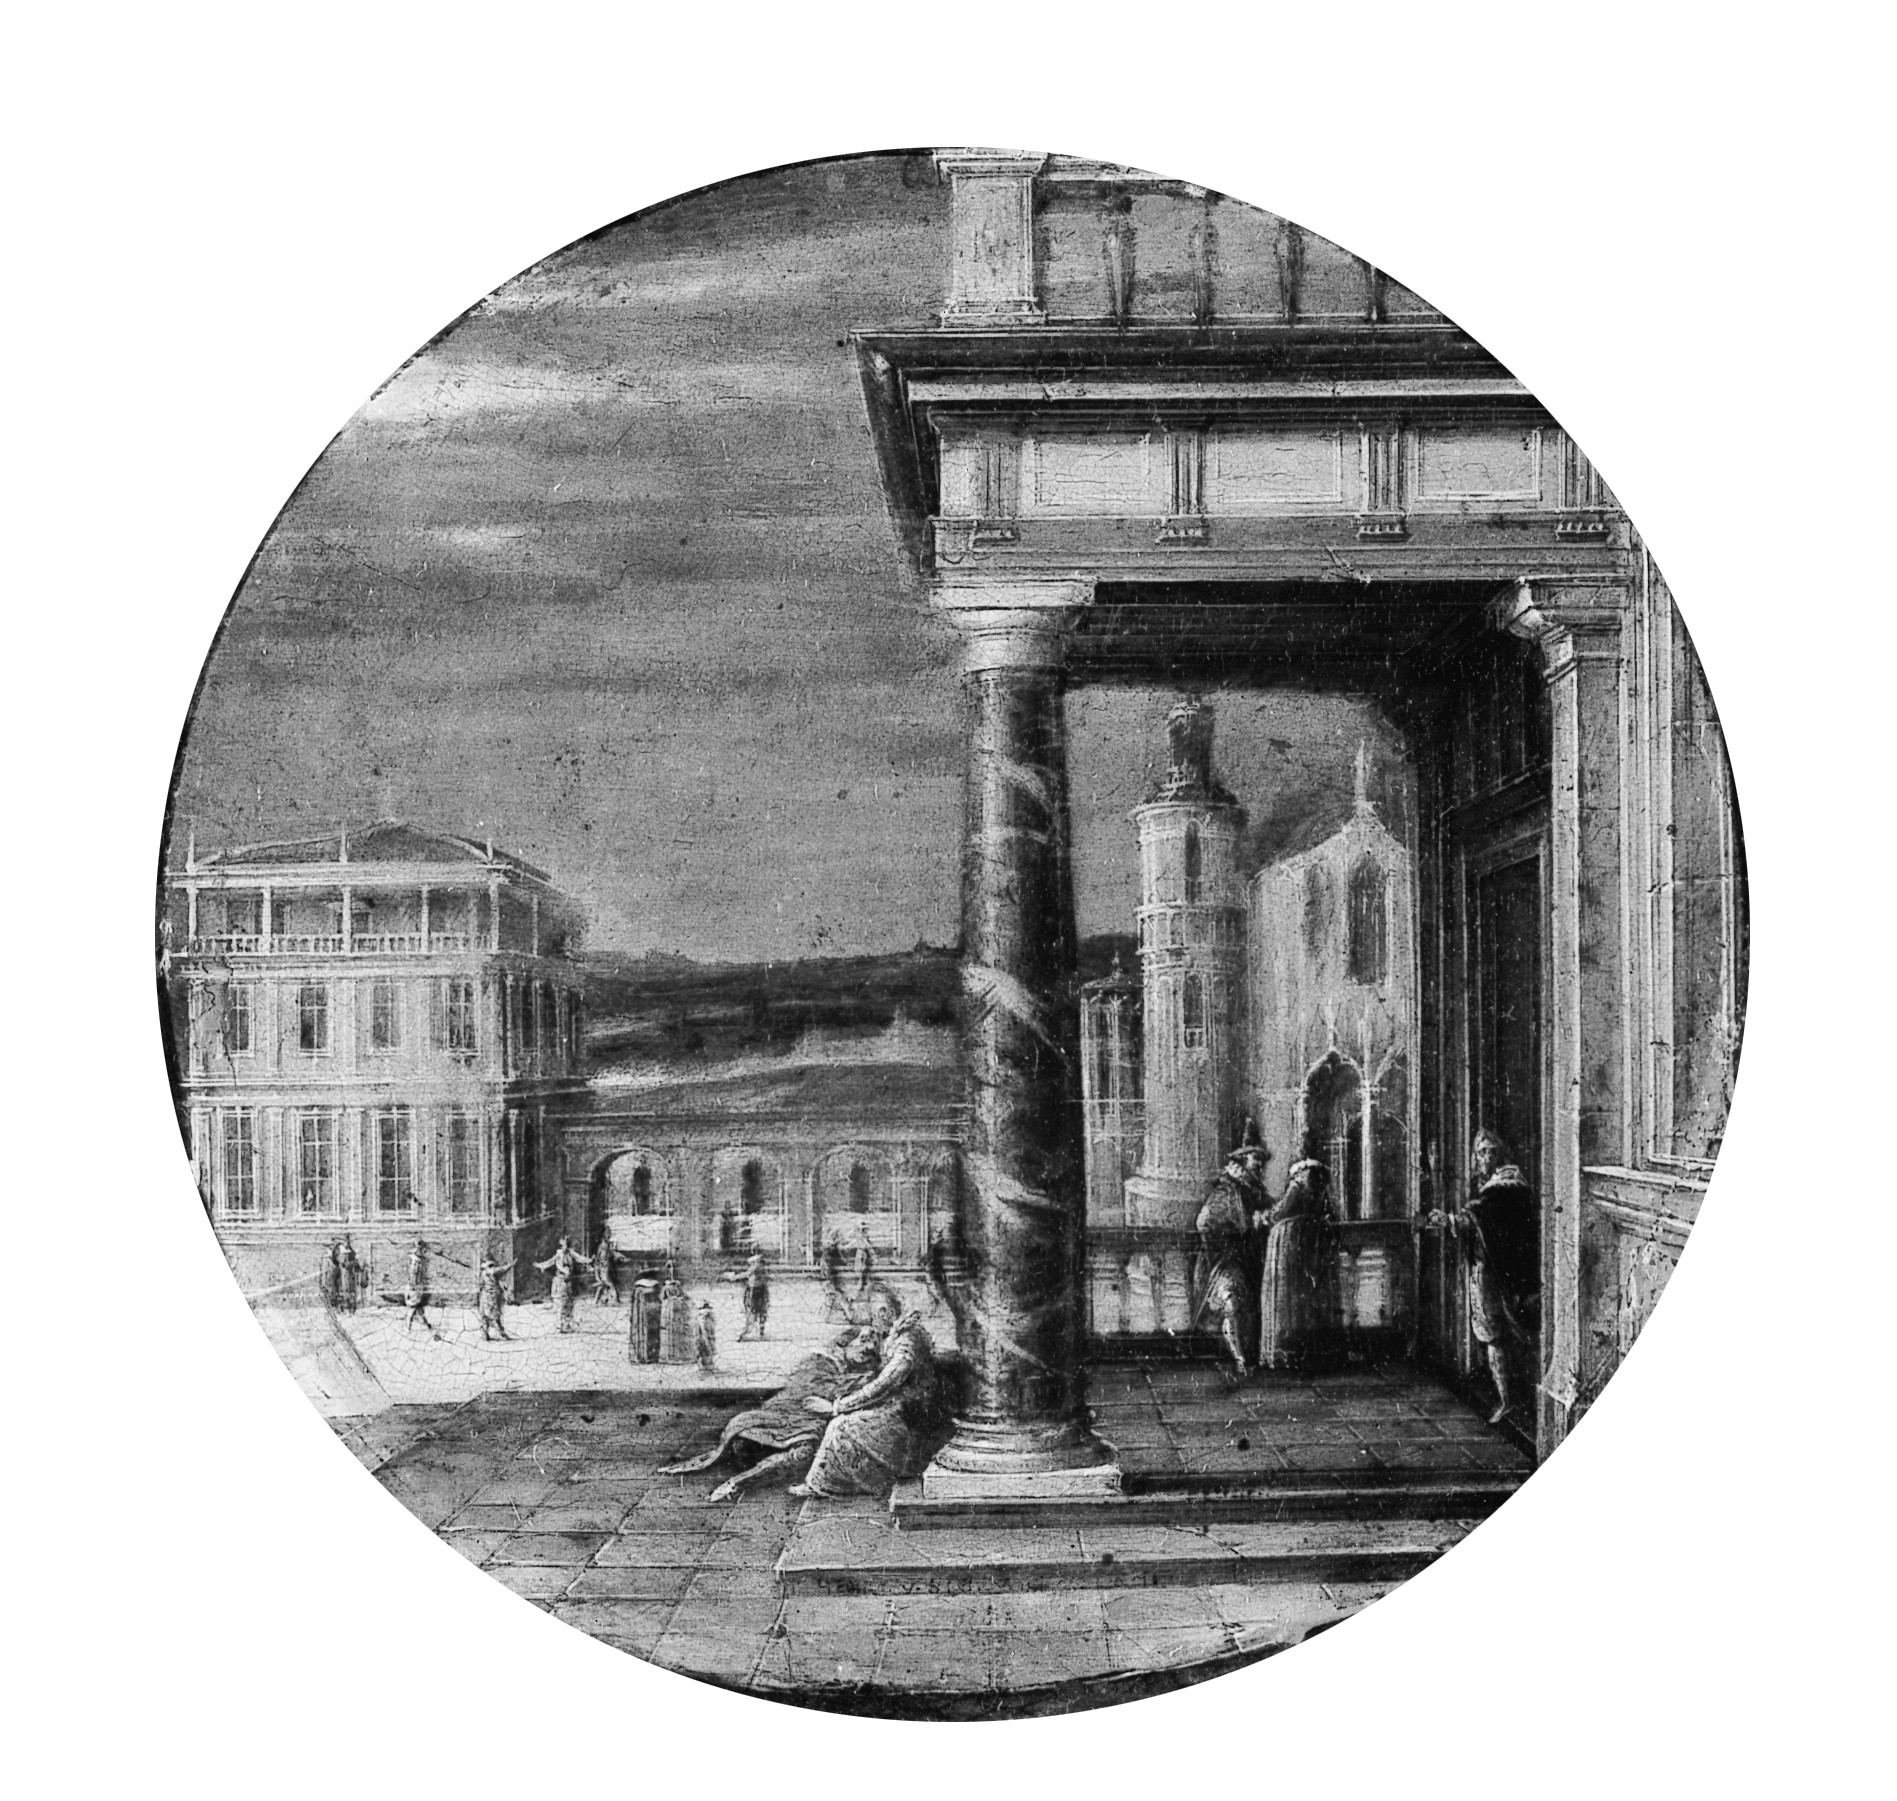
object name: painting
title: A Renaissance Portico with Elegant Figures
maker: hendrick van steenwijck ii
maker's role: artist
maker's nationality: flemish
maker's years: 1475-1649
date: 1615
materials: copper, oil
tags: buildings